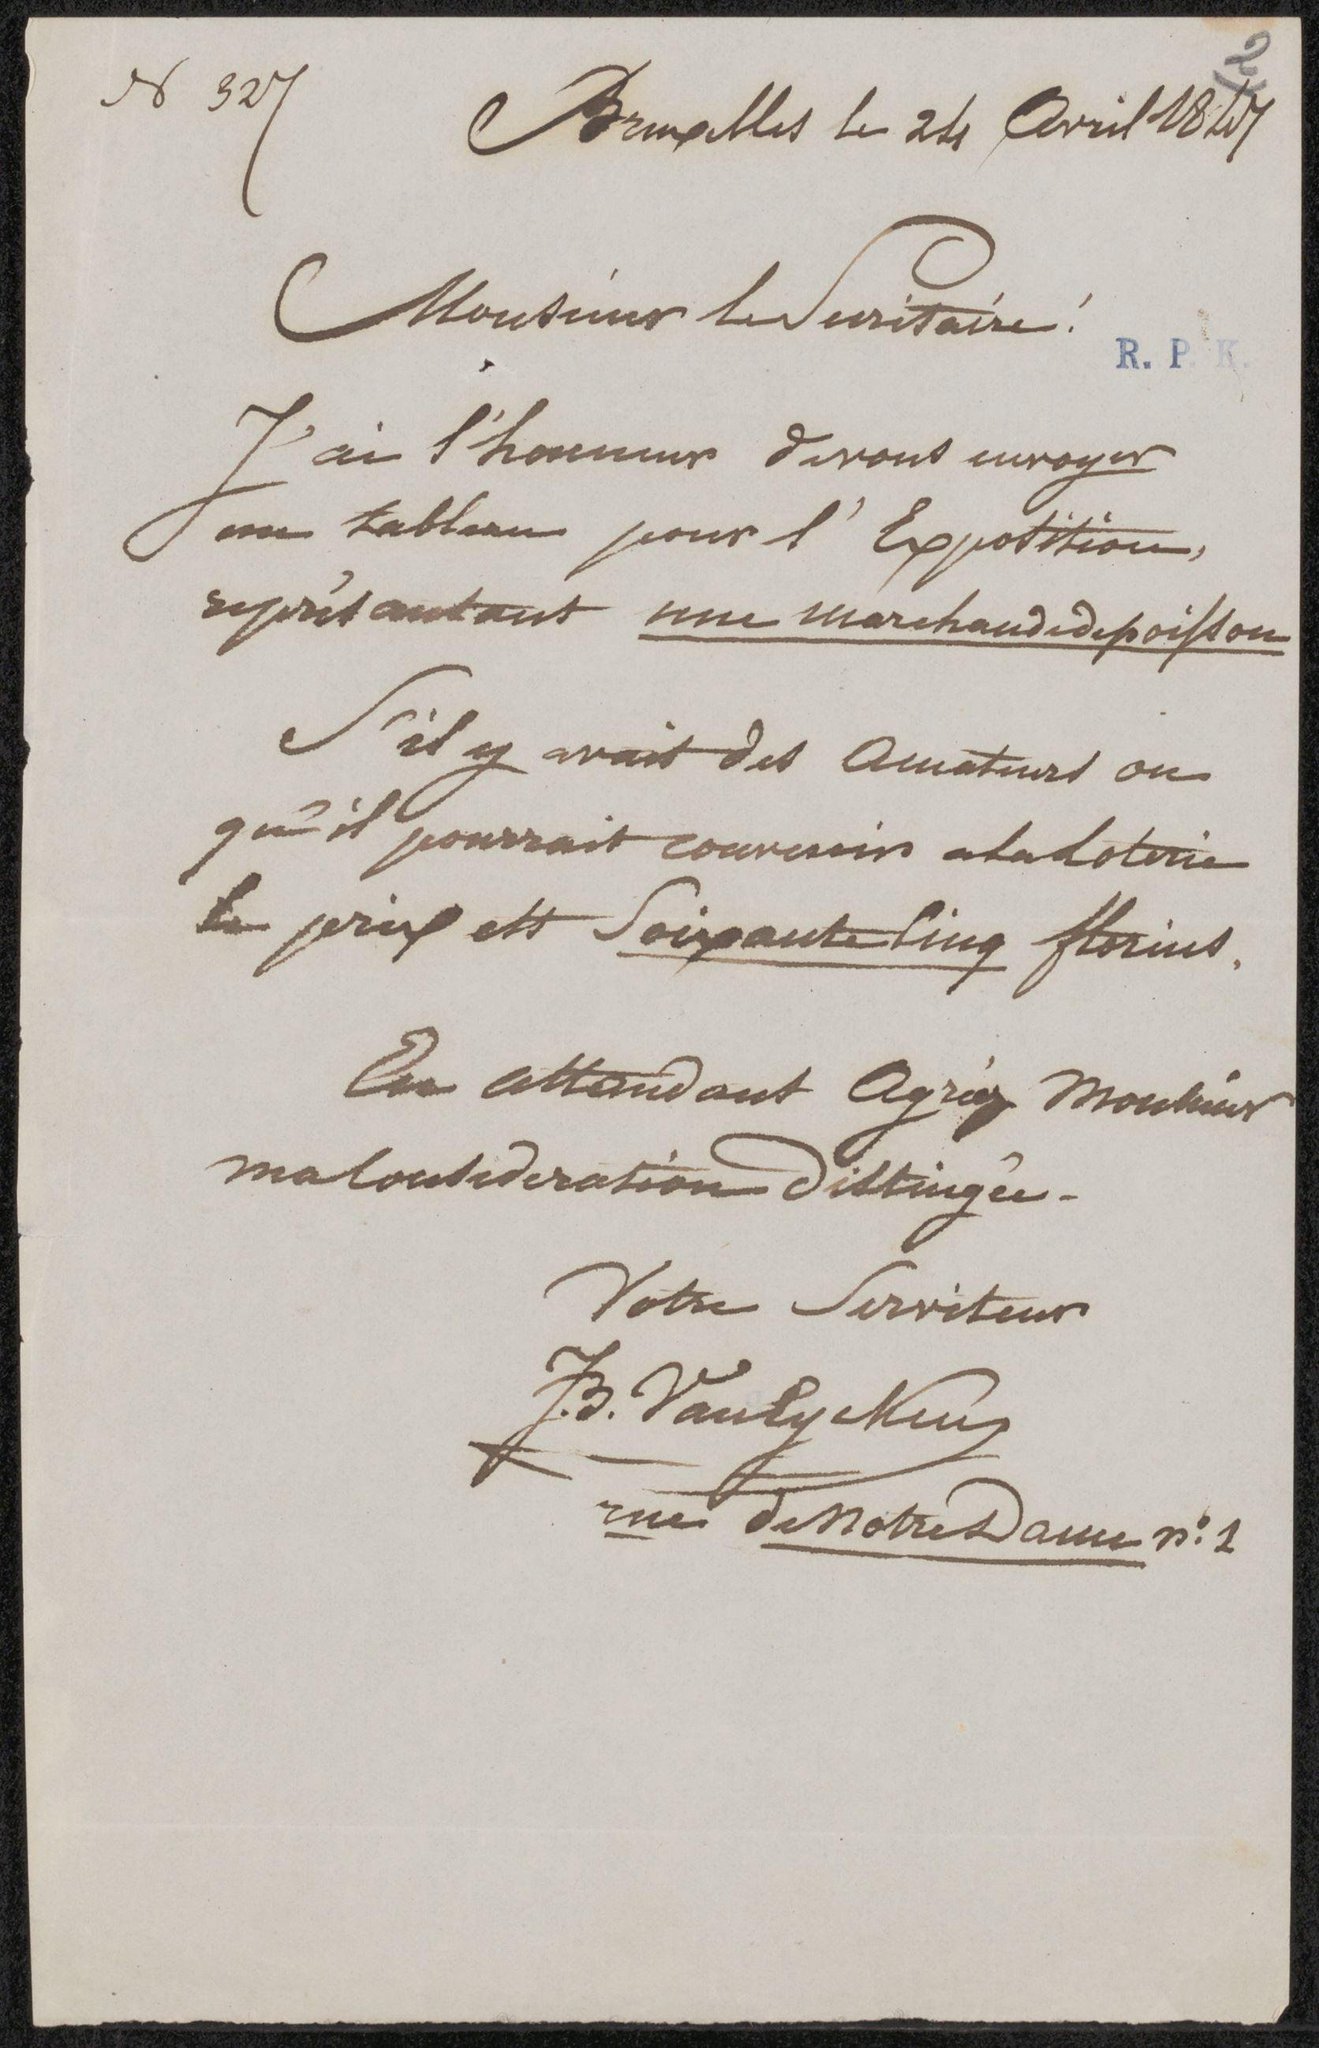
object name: letter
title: Brief aan de commissie van de Tentoonstelling van Levende Meesters in Den Haag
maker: jean baptiste van eycken (1809-1853)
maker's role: painter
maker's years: 1809-1853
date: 1847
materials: ink, paper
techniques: pen, writing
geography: brussels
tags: painting (including book-illumination, miniature-painting), exhibition ~ art, money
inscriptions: collector's mark: Lugt 2233